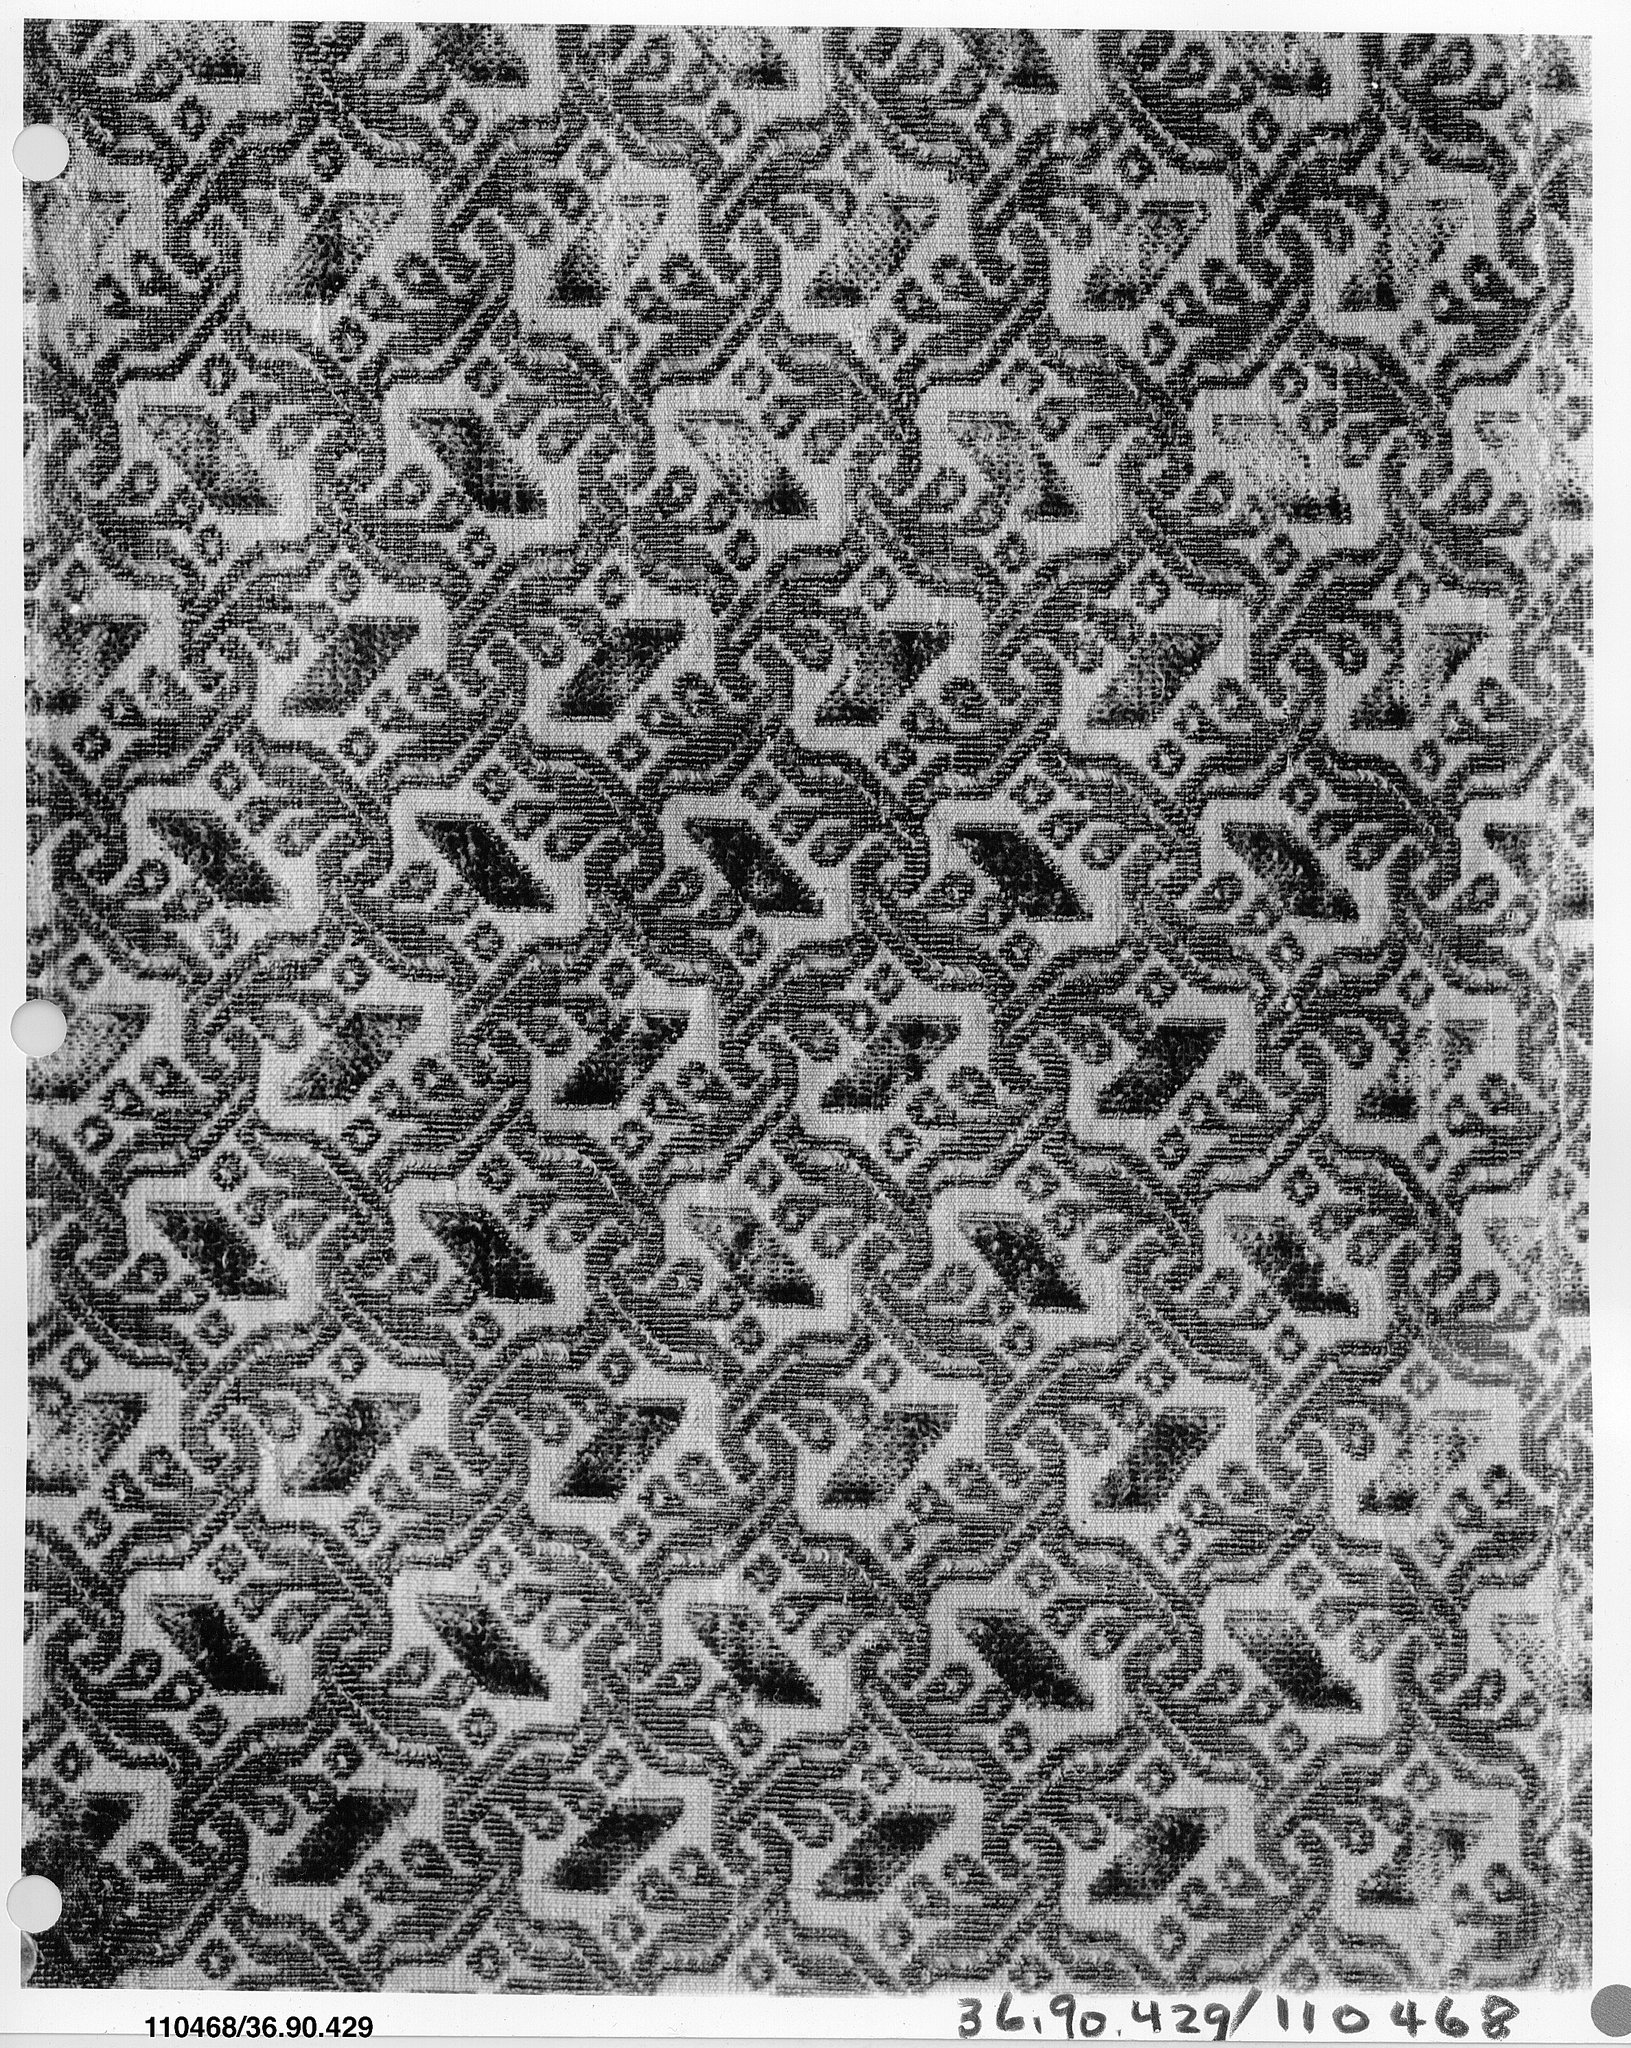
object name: piece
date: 1501-1700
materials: silk